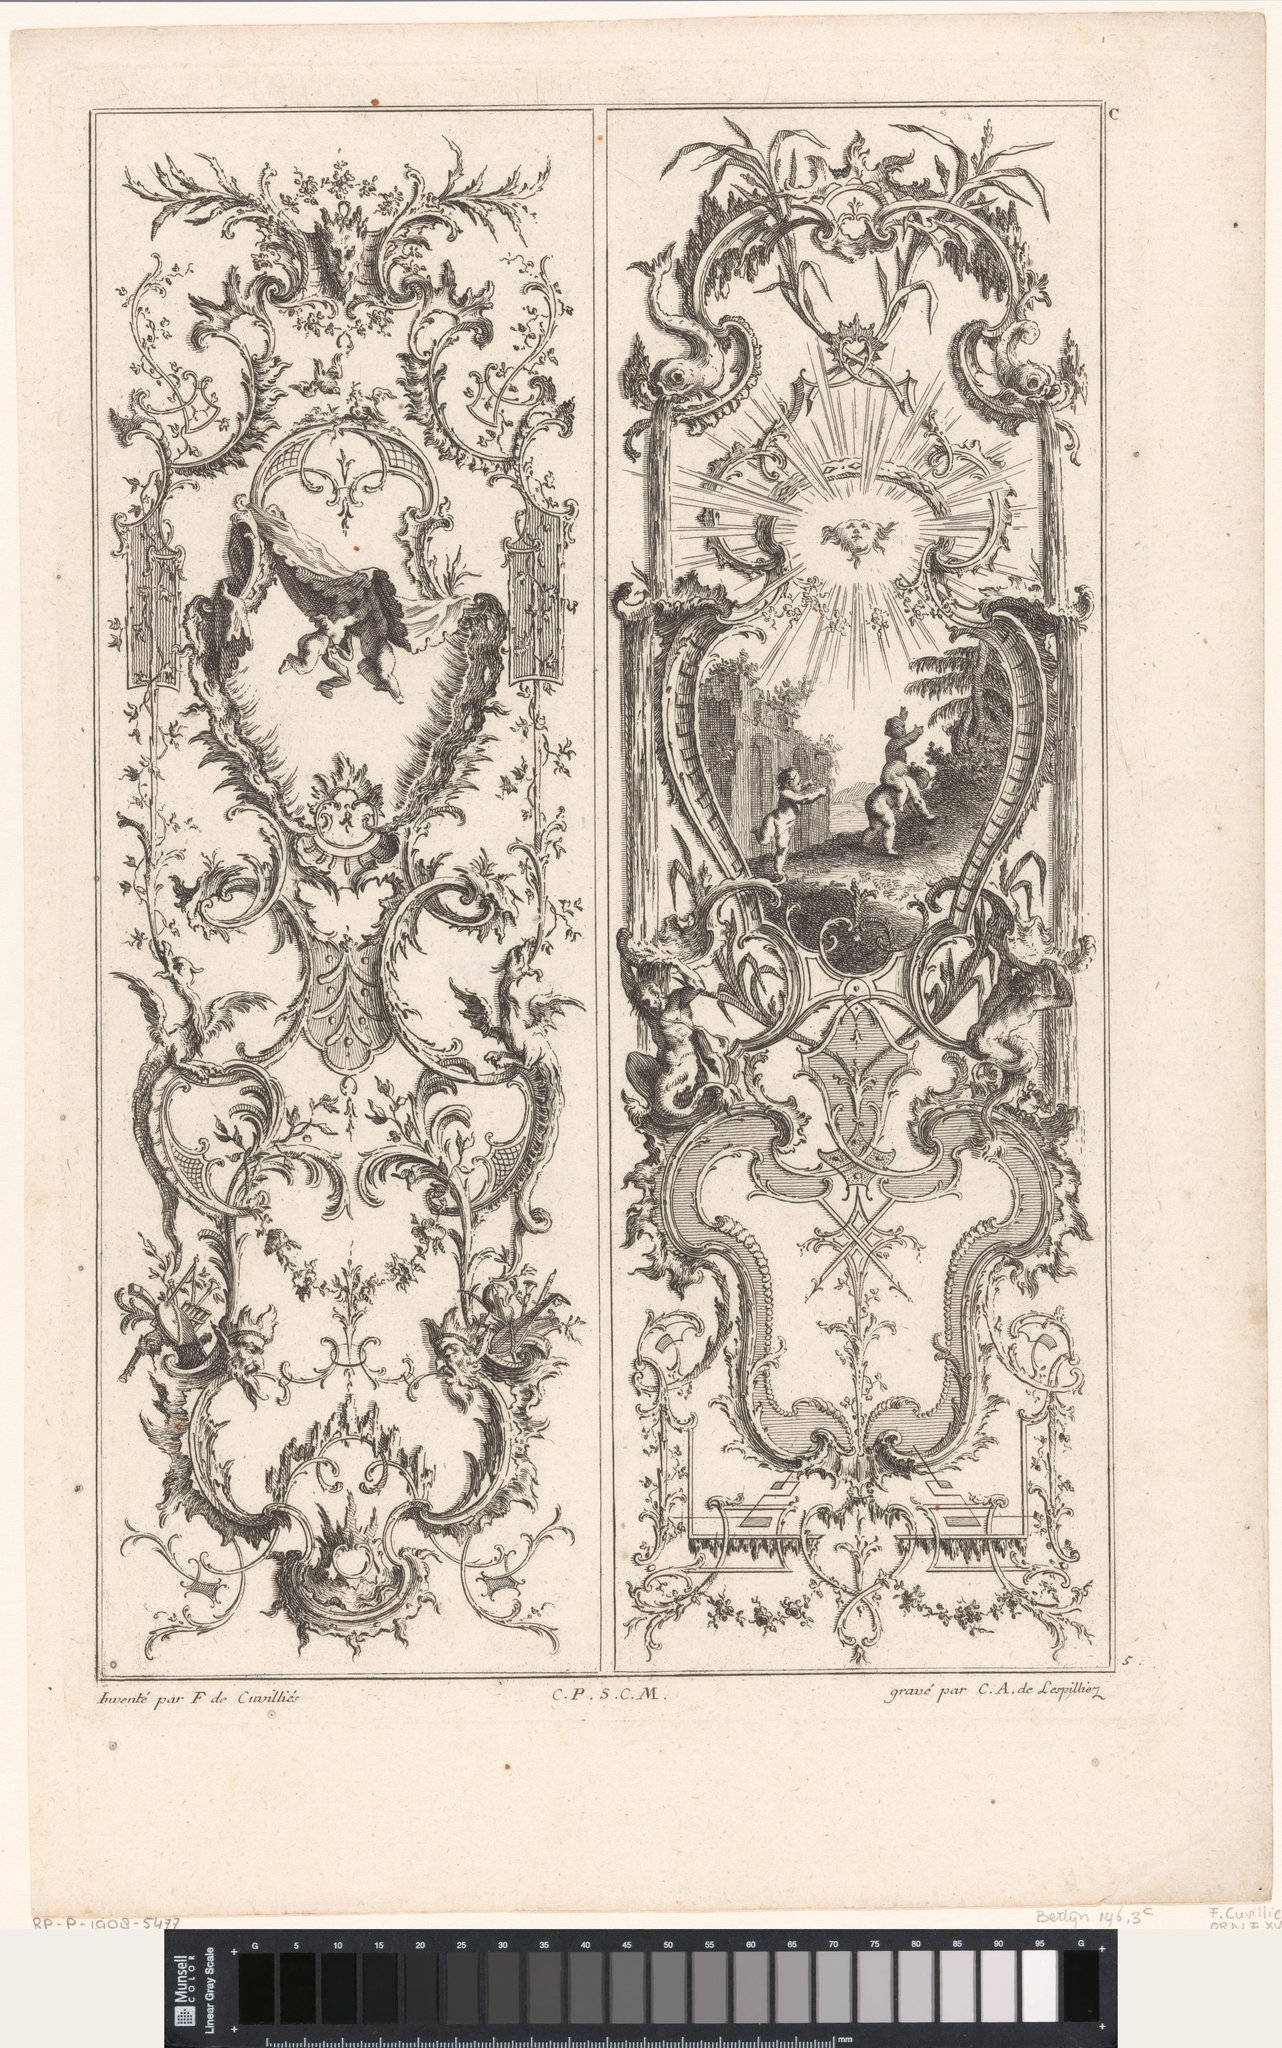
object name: print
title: 3me Livre C Livre de Paneaux a divers usages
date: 1745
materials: paper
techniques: etching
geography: germany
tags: musical instruments; group of musical instruments, dolphin ~ ornament, merman, ornament ~ arabesque, mask, mascaron ~ ornament, dragon, cupids: 'amores', 'amoretti', 'putti'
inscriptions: collector's mark: Lugt 2228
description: Twee verticale panelen gevuld met arabesken. Links met maskers, muziekinstrumenten, draken en in het midden twee vliegende putti met een doek. Rechts met dolfijnen, fonteinen, meermannen en in het midden drie spelende putti.